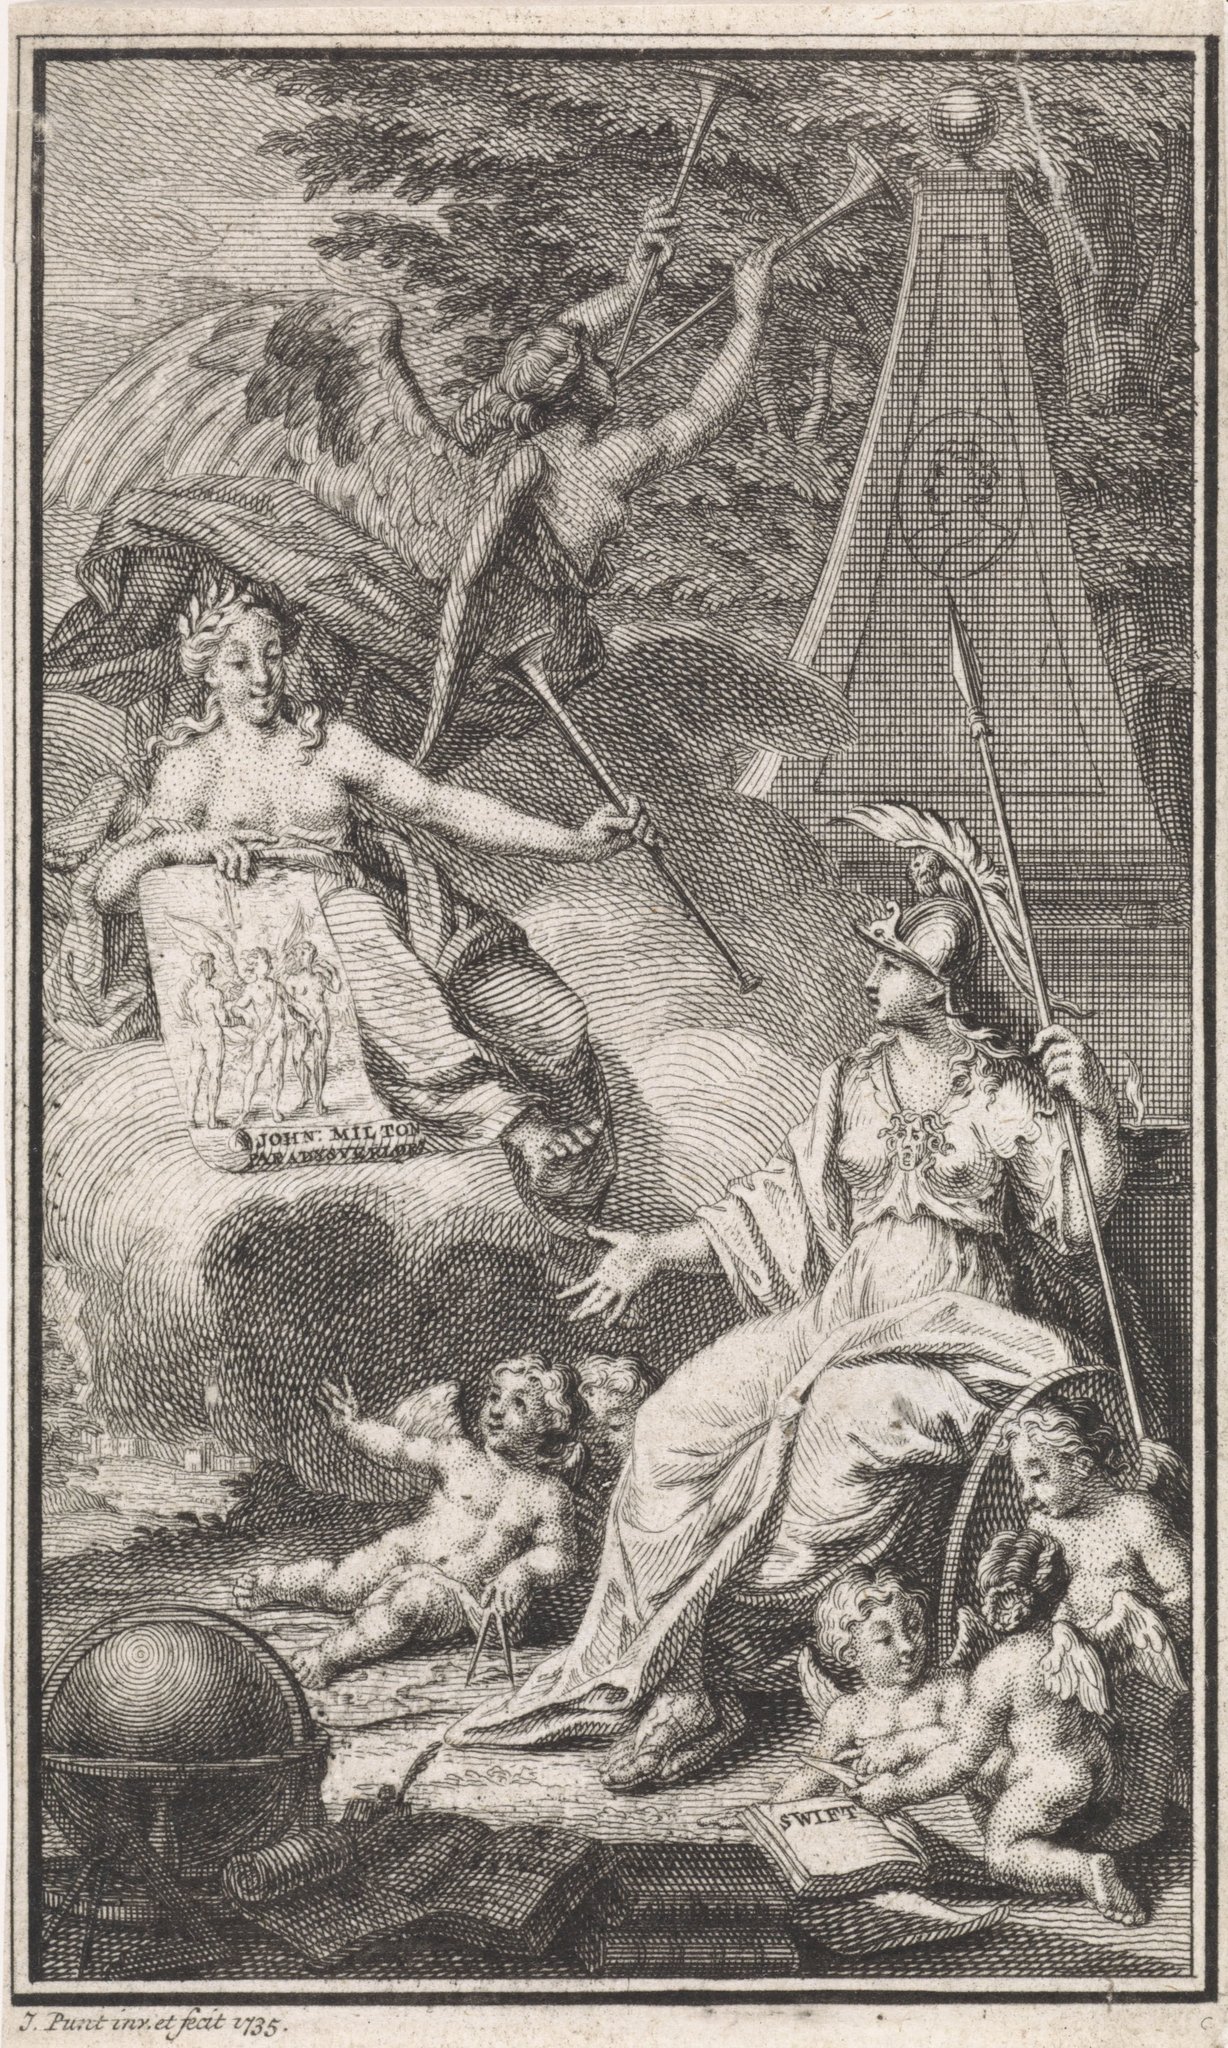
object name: print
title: Allegorische voorstelling met Minerva in een landschap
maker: jan punt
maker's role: draughtsman, print maker, publisher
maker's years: 1711-1779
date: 1735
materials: paper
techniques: engraving, etching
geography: amsterdam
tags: london, john milton, (story of) minerva (pallas, athena), expulsion of adam and eve from paradise (genesis 3:22-24), fame; 'fama', 'fama buona', 'fama chiara' (ripa), globe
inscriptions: collector's mark: Lugt 2228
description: Minerva zit in een landschap bij een monument waarop het portret van de dichter John Milton. Aan haar voeten spelen drie putti met diens boeken, en een vierde met een passer. Minerva kijkt op naar een allegorische figuur die haar een vel papier toont. Op het vel een voorstelling van Adam en Eva die door de engel uit het Paradijs gezet zijn, en de titel van het boek in het Nederlands. In de lucht Faam, blazend op haar bazuin, in de richting van het monument.